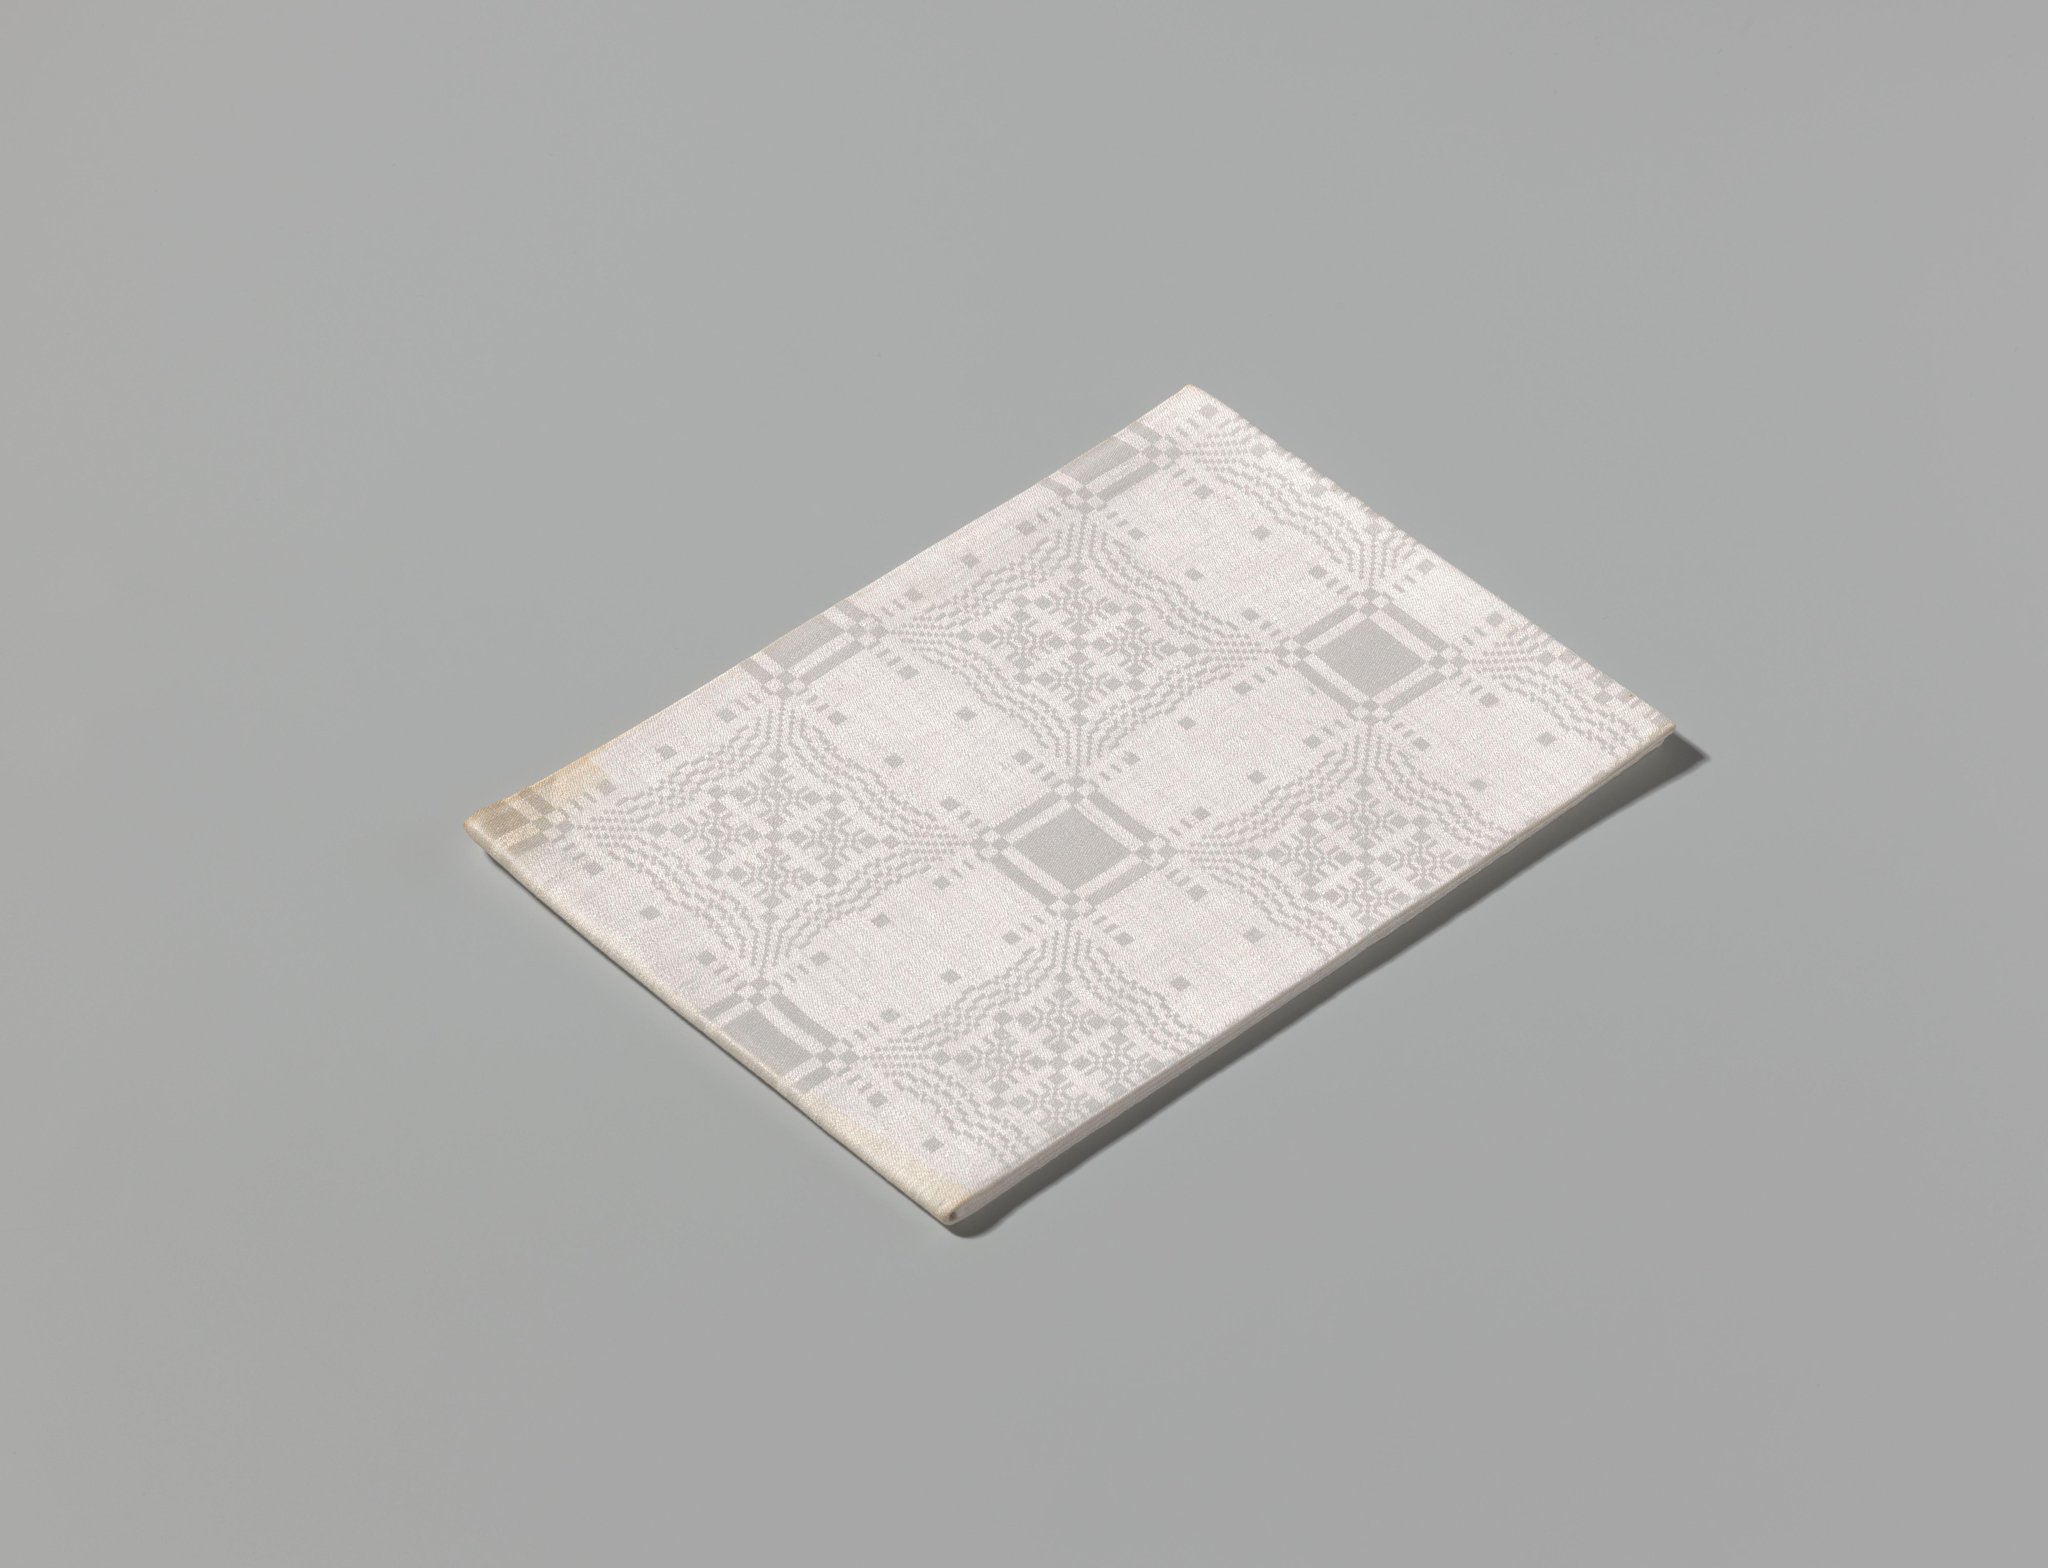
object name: napkin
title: Servet van linnen met pellenpatroon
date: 1734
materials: linen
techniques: peeled fabric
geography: northern netherlands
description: wit linnen servet met pellen patroon, merk AVG 38 en 1734